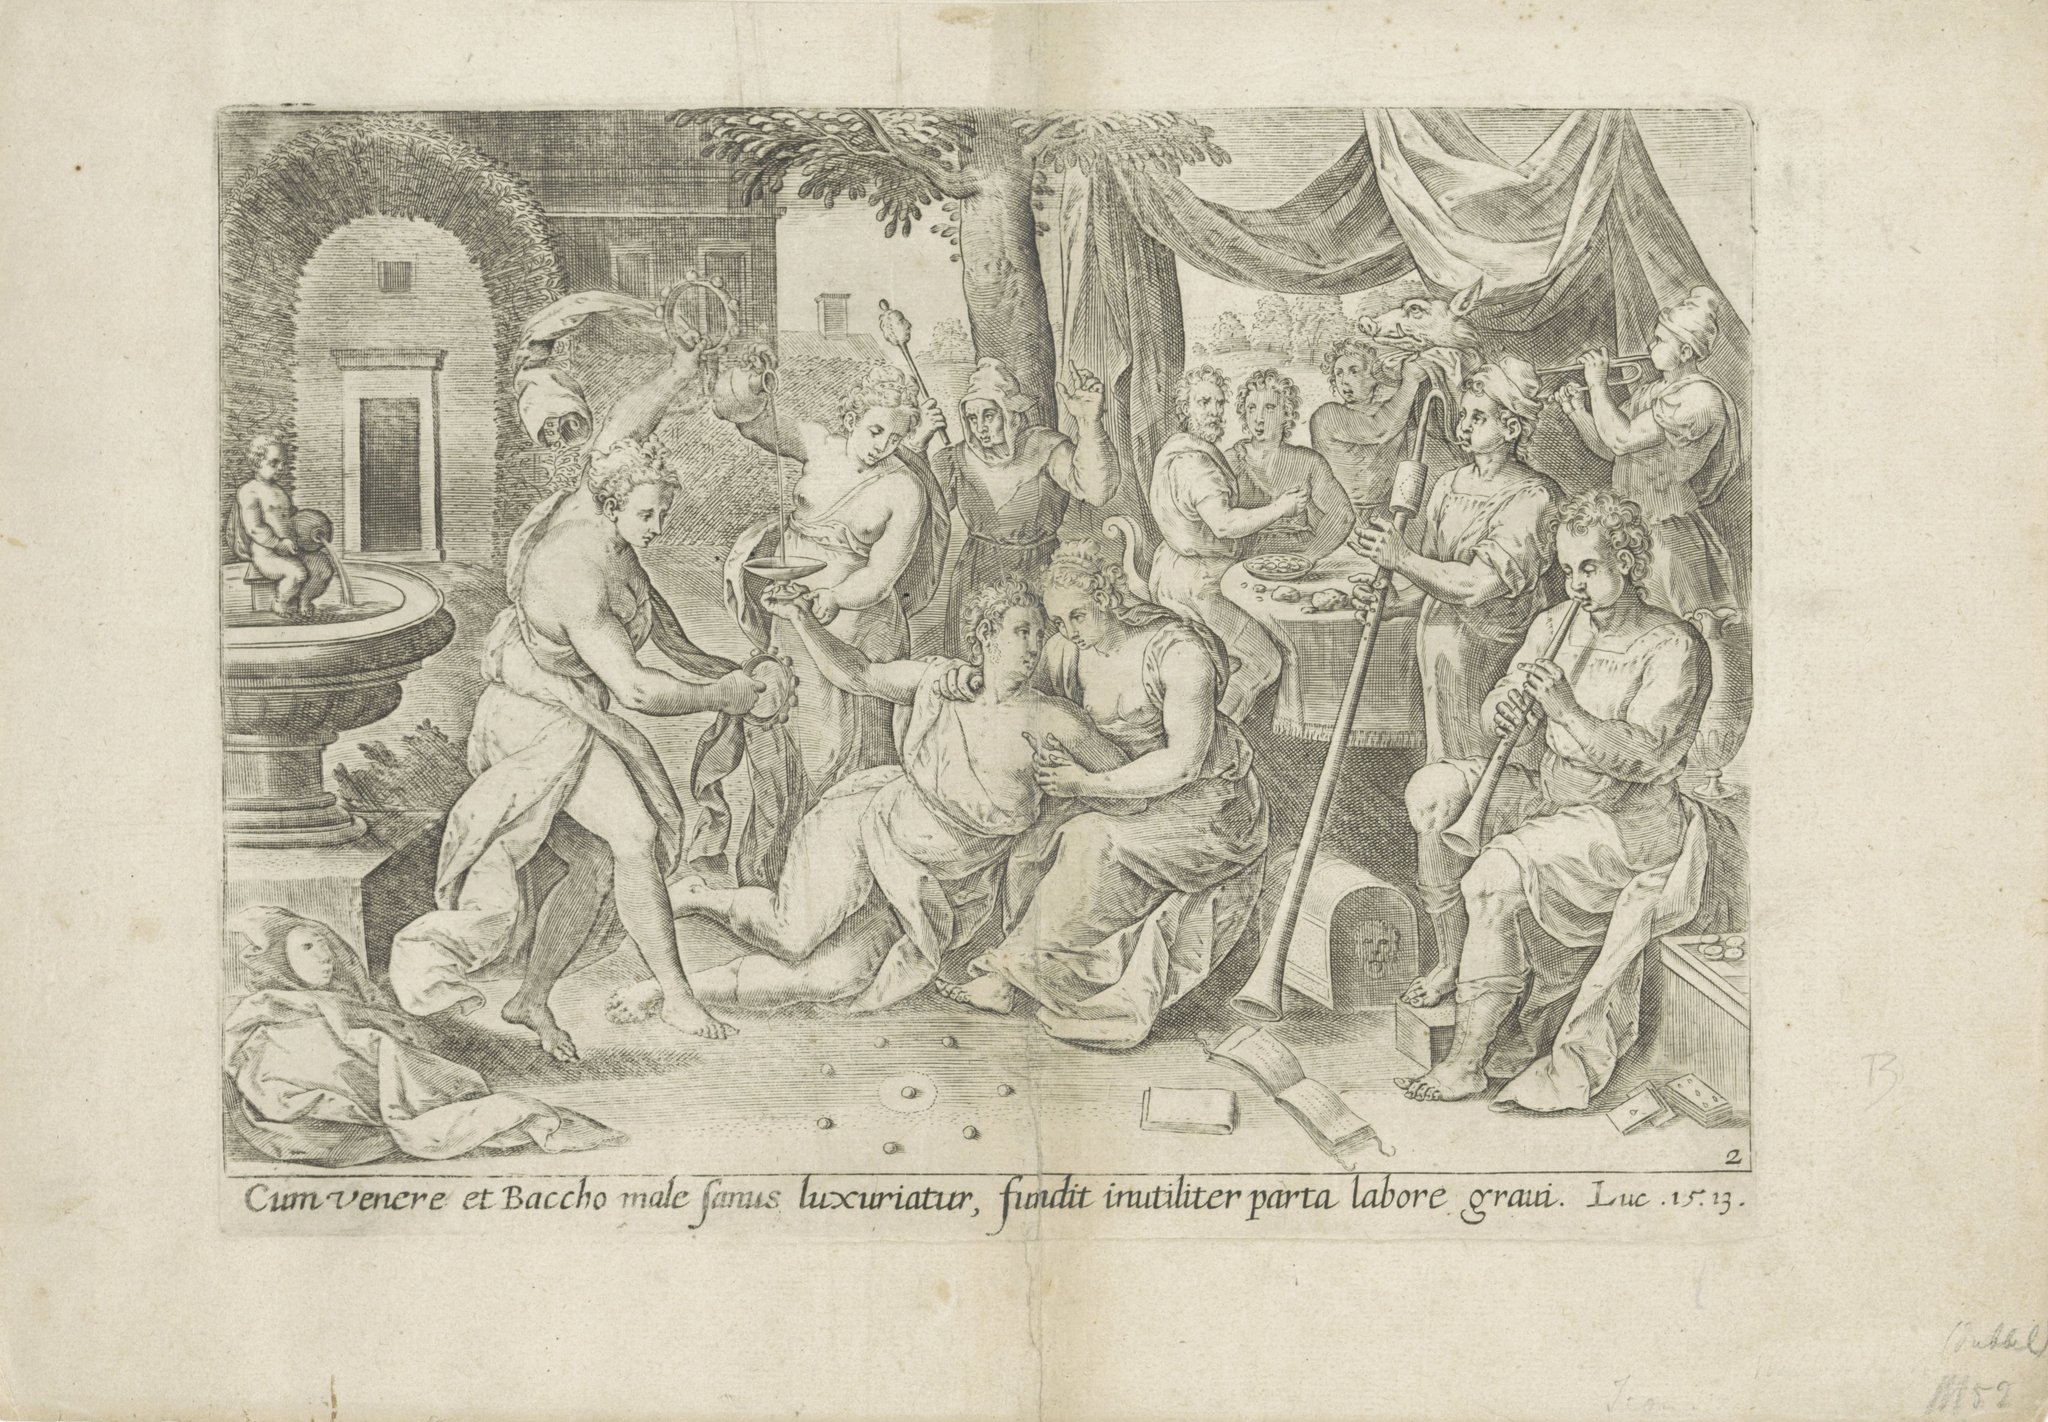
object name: print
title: Theatrum biblicum (...)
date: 1585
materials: paper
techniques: engraving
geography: amsterdam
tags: the prodigal son in the midst of prostitutes feasting and dissipating his patrimony, usually in a brothel or inn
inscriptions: collector's mark: Lugt 2228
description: De verloren zoon verkwist zijn erfenis in een bordeel. In een tuin wordt hij omarmd door een prostituee. Een andere vrouw schenkt zijn glas vol. Links een dansende vrouw met tamboerijnen en rechts een orkest. Achter de verloren zoon staat een nar. Onder de voorstelling een verwijzing in het Latijn naar de Bijbeltekst in Luc. 15:13.